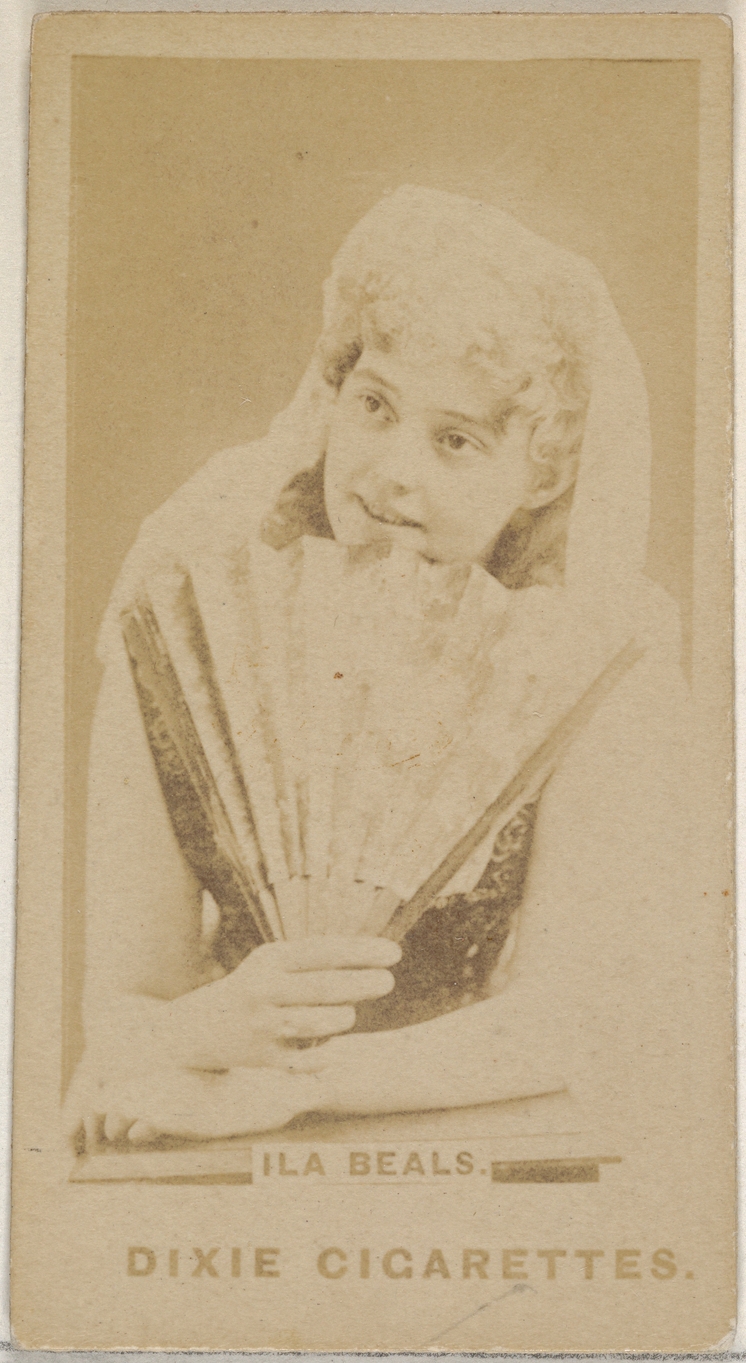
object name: photograph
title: Ila Beals, from the Actors and Actresses series (N45, Type 7) for Dixie Cigarettes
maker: allen & ginter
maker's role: publisher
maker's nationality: american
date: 1888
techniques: albumen silver print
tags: fans,portraits,women,actresses